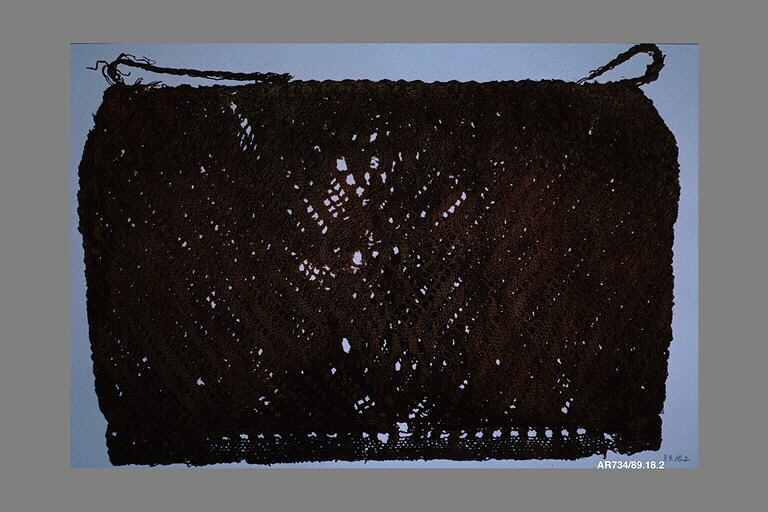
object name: cap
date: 201-400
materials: wool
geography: egypt